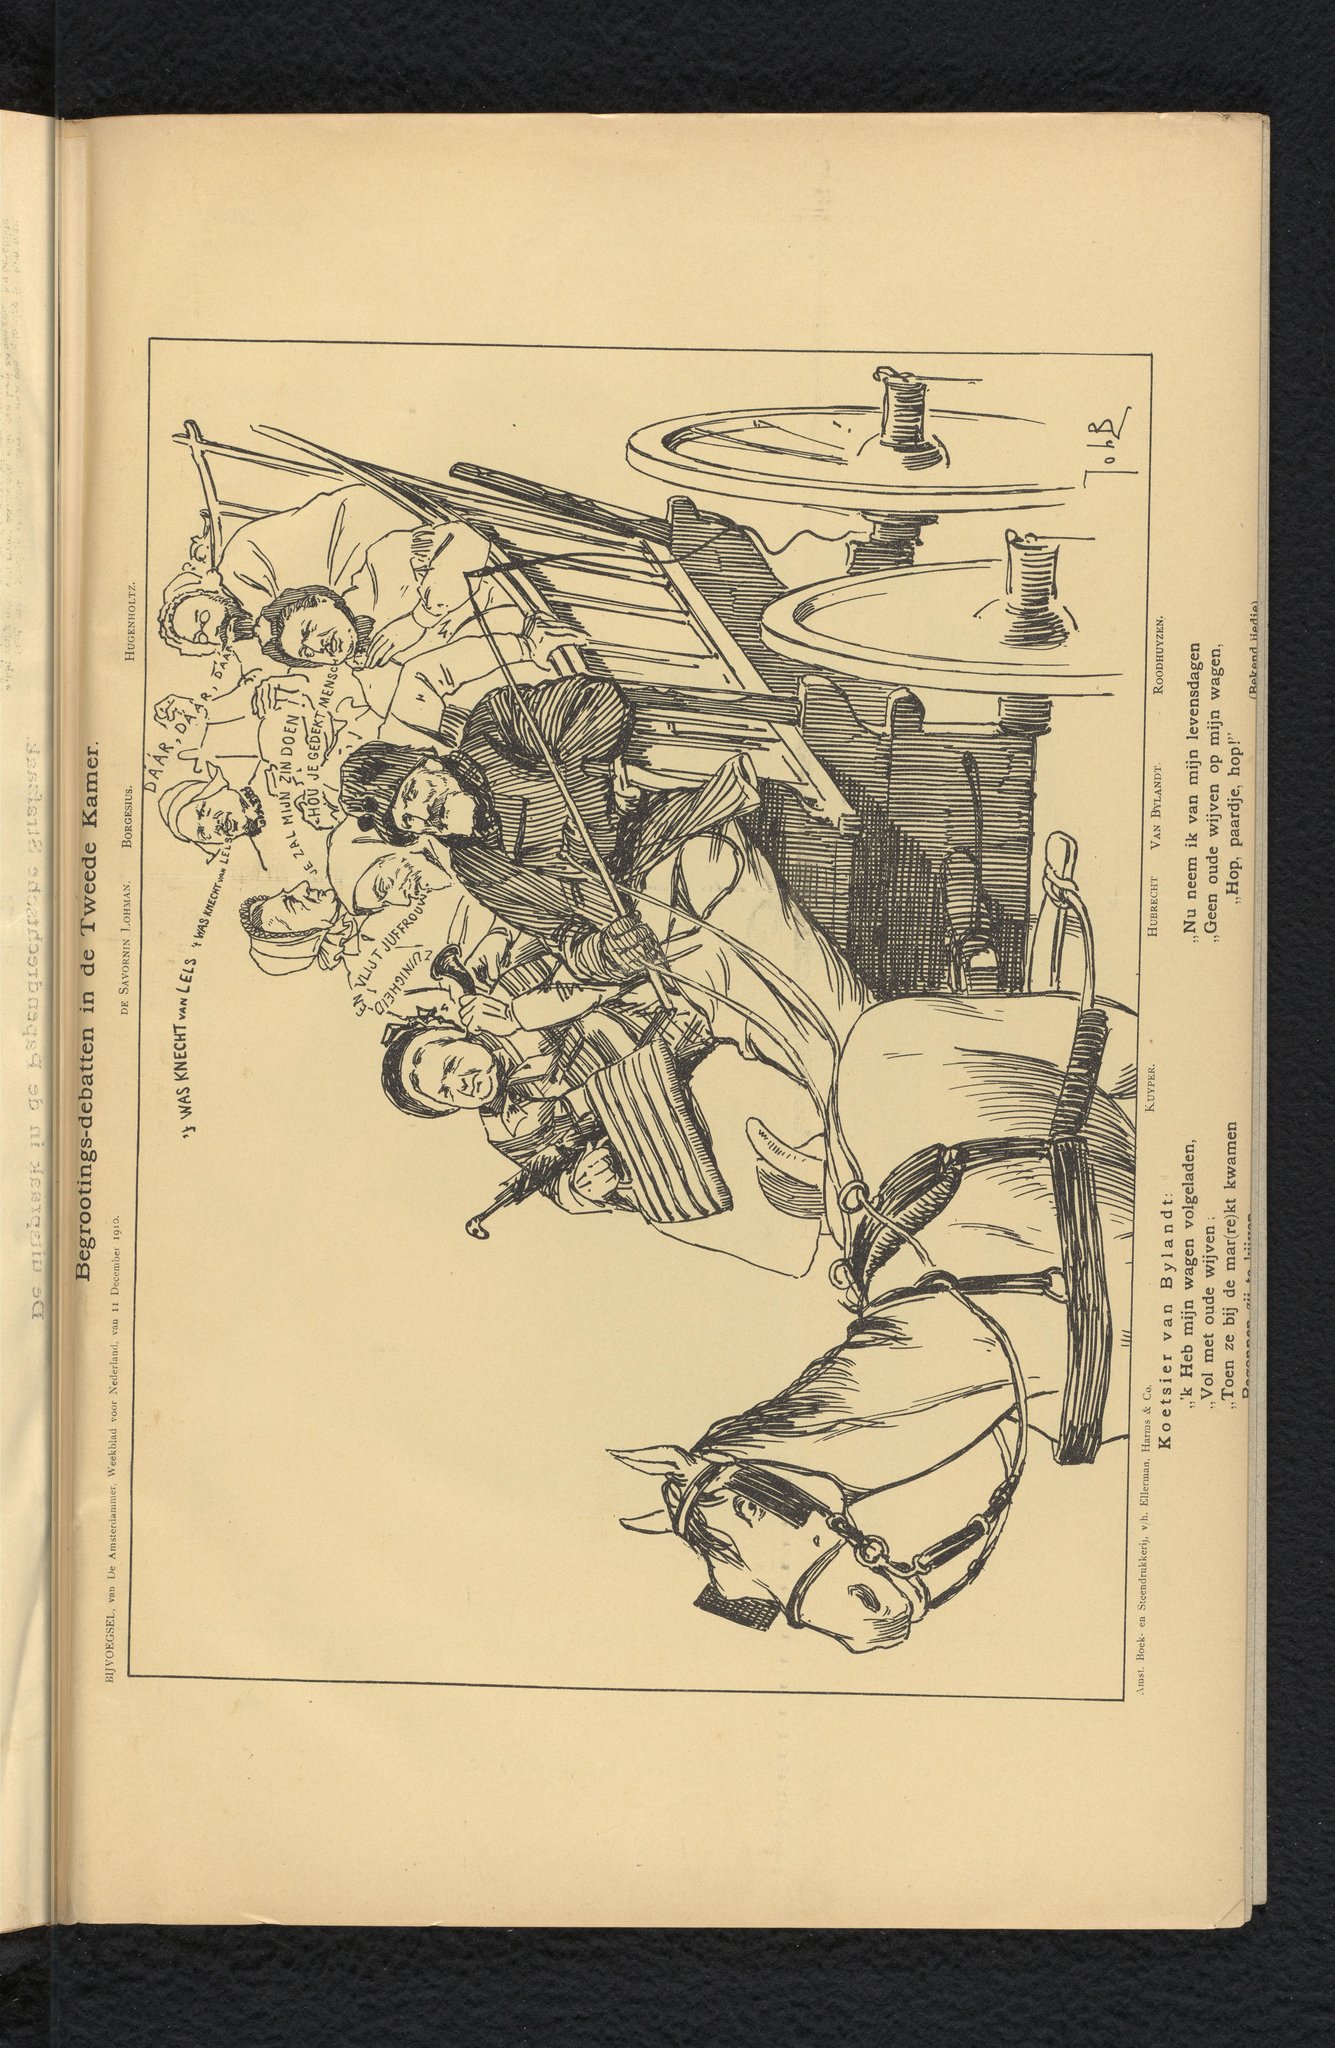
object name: cartoon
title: Begrootings-debatten in de Tweede Kamer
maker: johan braakensiek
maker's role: draughtsman, print maker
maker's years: 1858-1940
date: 1910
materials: paper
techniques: lithograph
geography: amsterdam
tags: zeist, the hague, abraham kuyper, four-wheeled vehicle drawn by one animal, debate, discussion (~ parliament), political caricatures and satires, whip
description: Tweede Kamervoorzitter Frederik van Bylandt als koetsier met een 'wagen volgeladen met oude wijven', Kamerleden die door elkaar praten. Naast Bylandt op de bok zit Abraham Kuyper. Onderaan een aantal regels uit het bekende lied. Hij was als Kamervoorzitter niet opgewassen tegen zijn taak.